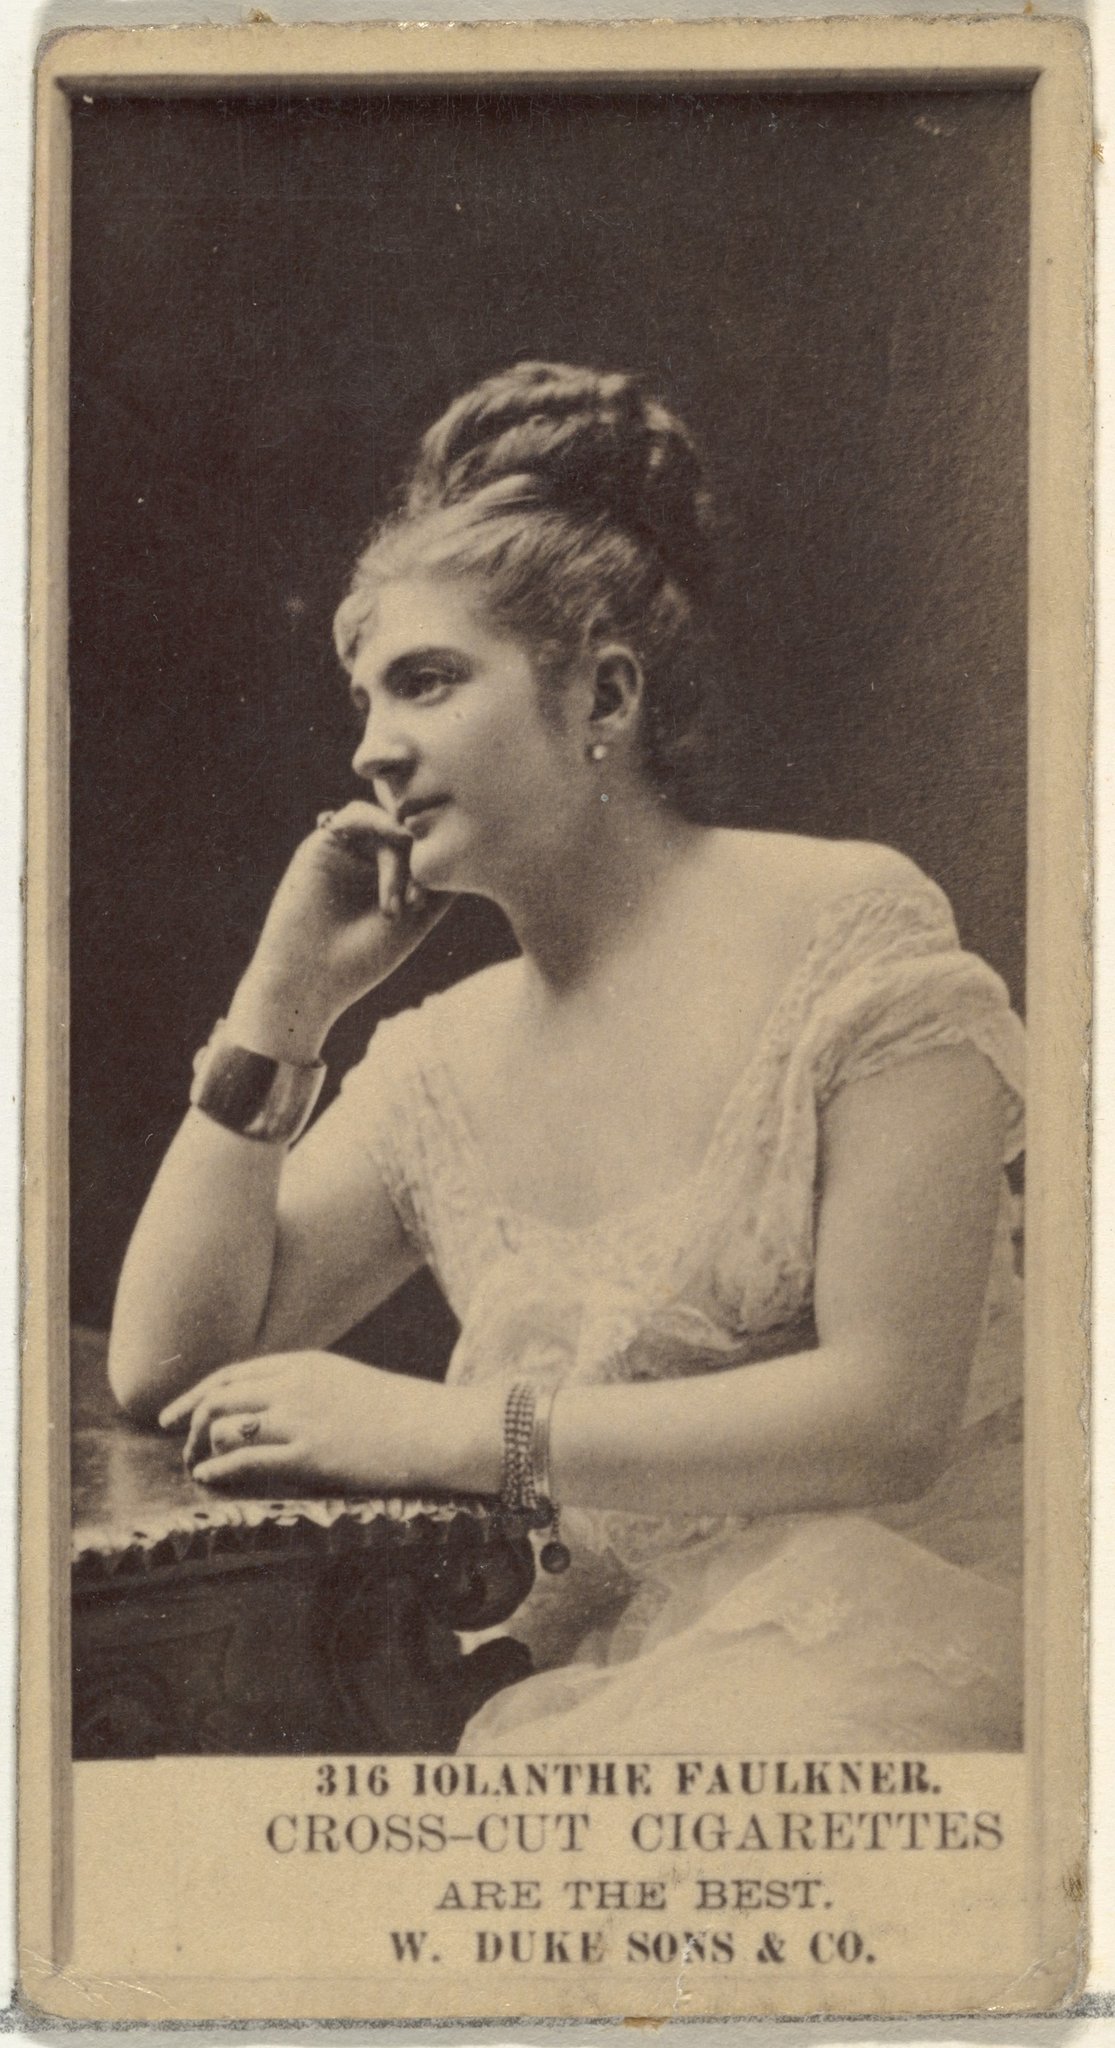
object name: photograph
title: Card Number 316, Iolanthe Faulkner, from the Actors and Actresses series (N145-3) issued by Duke Sons & Co. to promote Cross Cut Cigarettes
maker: w. duke, sons & co.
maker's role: publisher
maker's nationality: american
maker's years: 1870-1920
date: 1880-1889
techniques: albumen silver print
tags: women,actresses